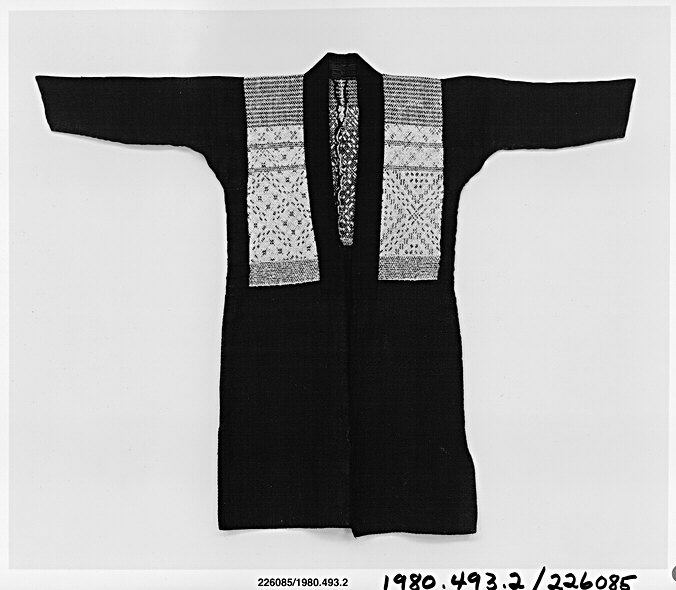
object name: farmer's jacket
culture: japanese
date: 1801-1900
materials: cotton, linen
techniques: embroidery